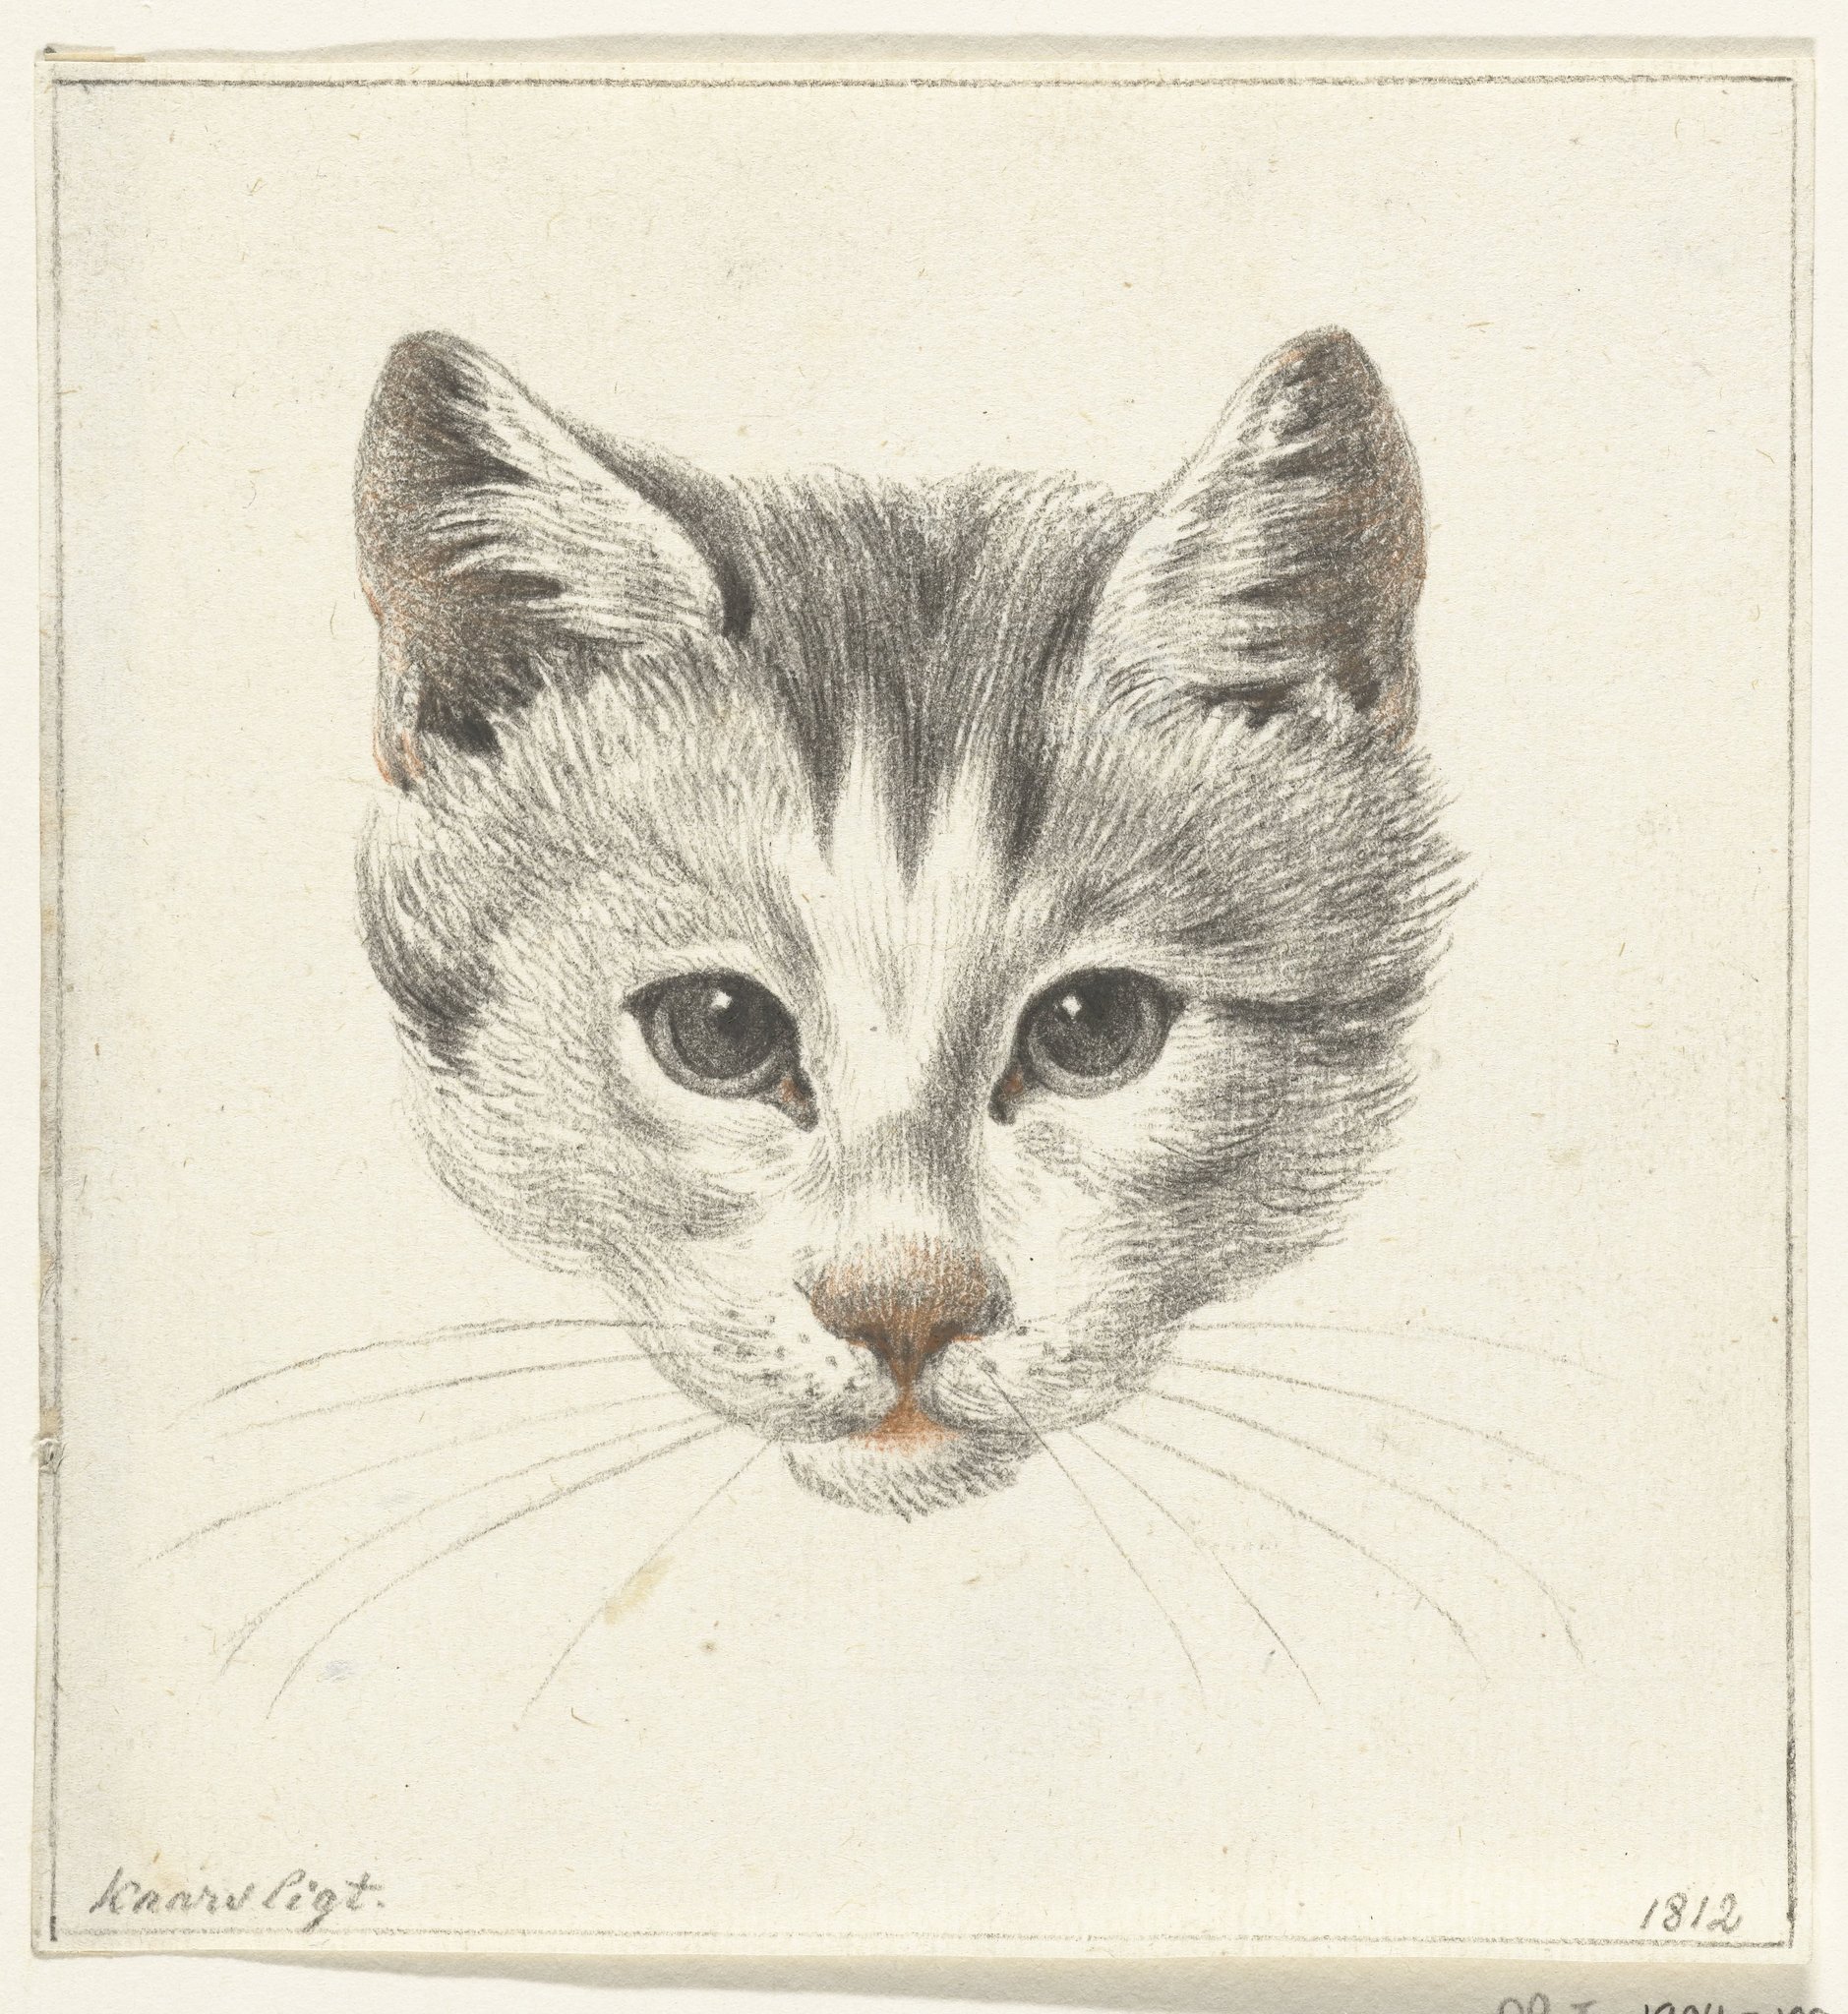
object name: drawing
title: Kop van een kat, van voren gezien bij kaarslicht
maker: jean bernard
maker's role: draughtsman, print maker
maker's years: 1765-1833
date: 1812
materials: chalk, paper, pencil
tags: cat